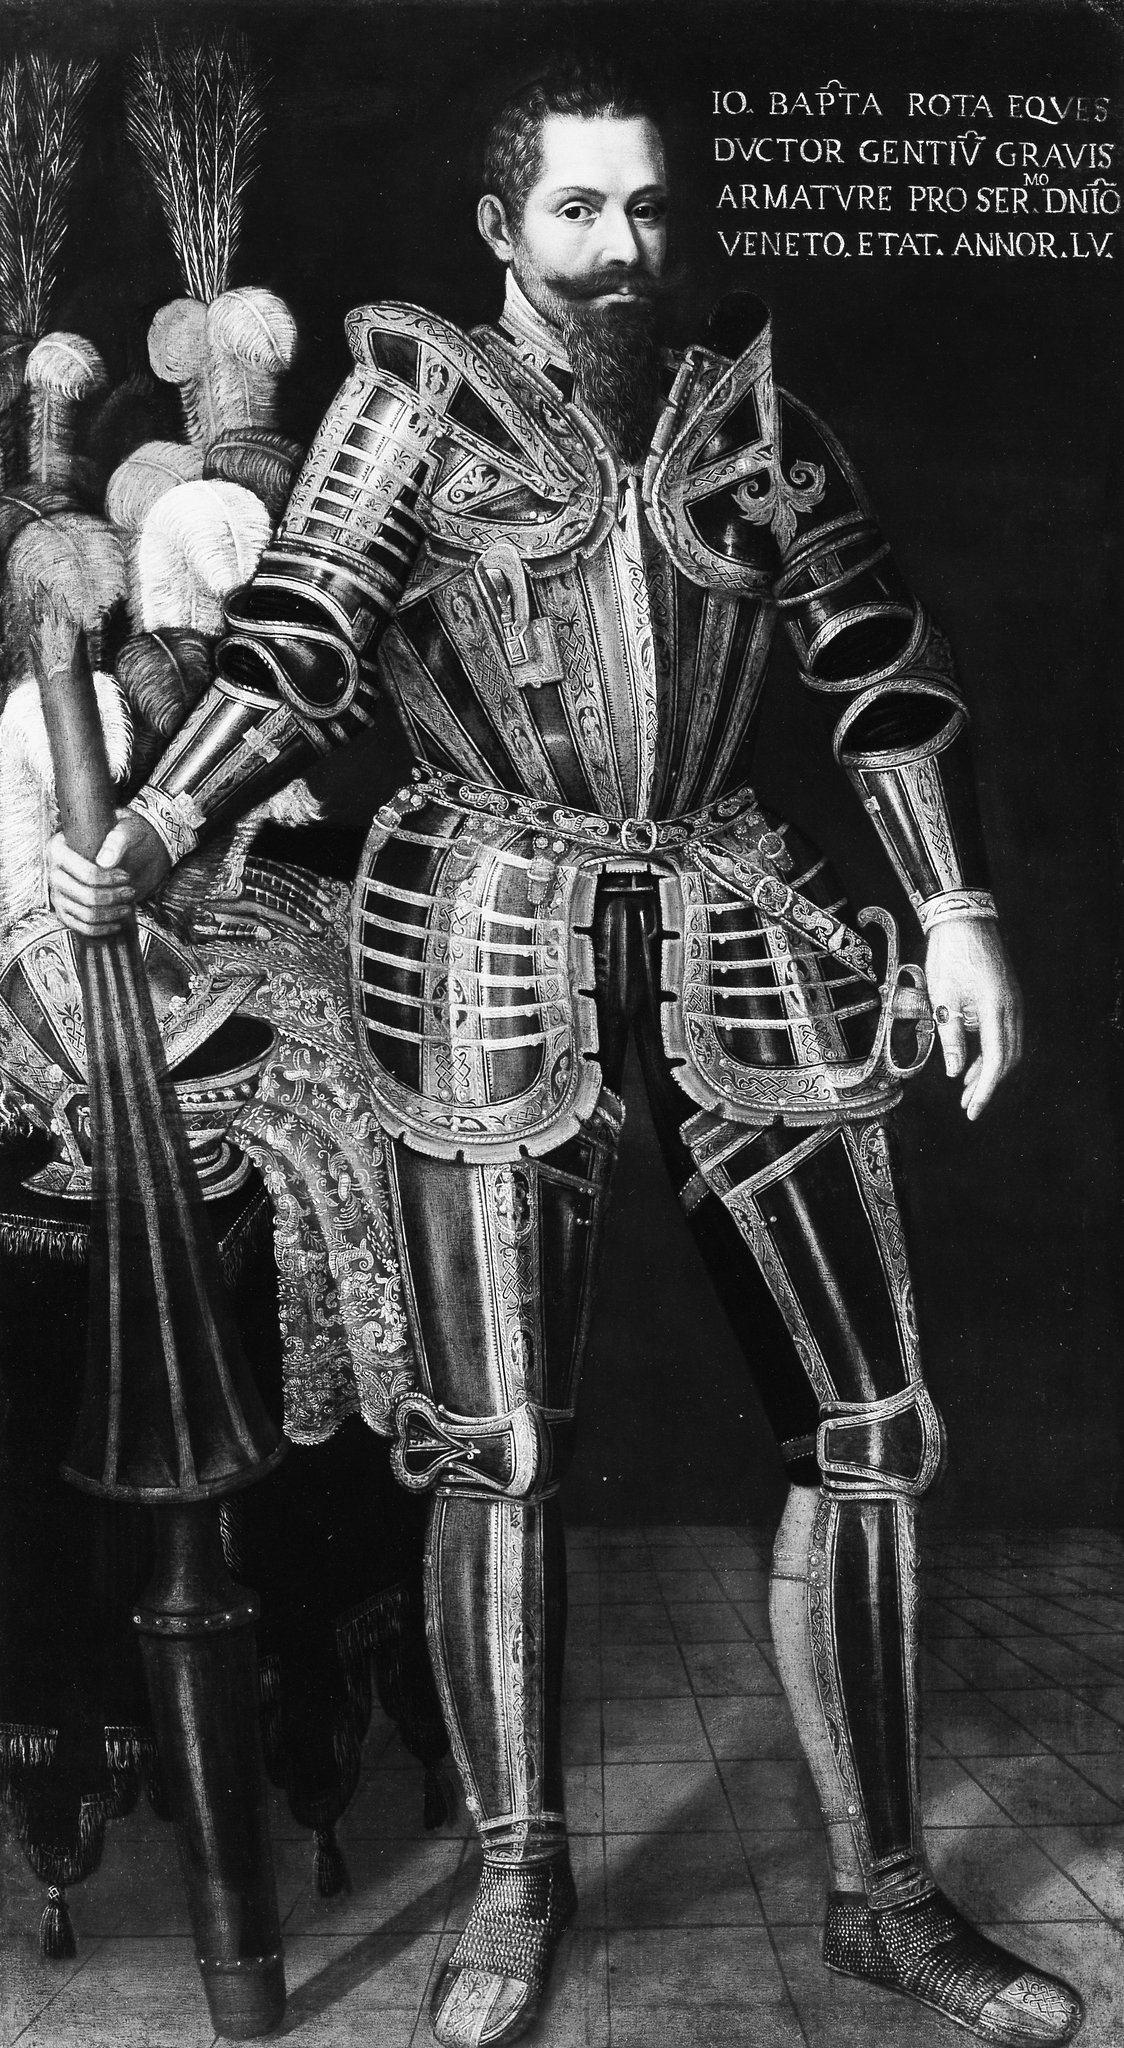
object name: painting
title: Giovanni Battista Rota, Member of the Rota Family of Venice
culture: italian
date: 1567-1600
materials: canvas, oil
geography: italy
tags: armor,men,portraits